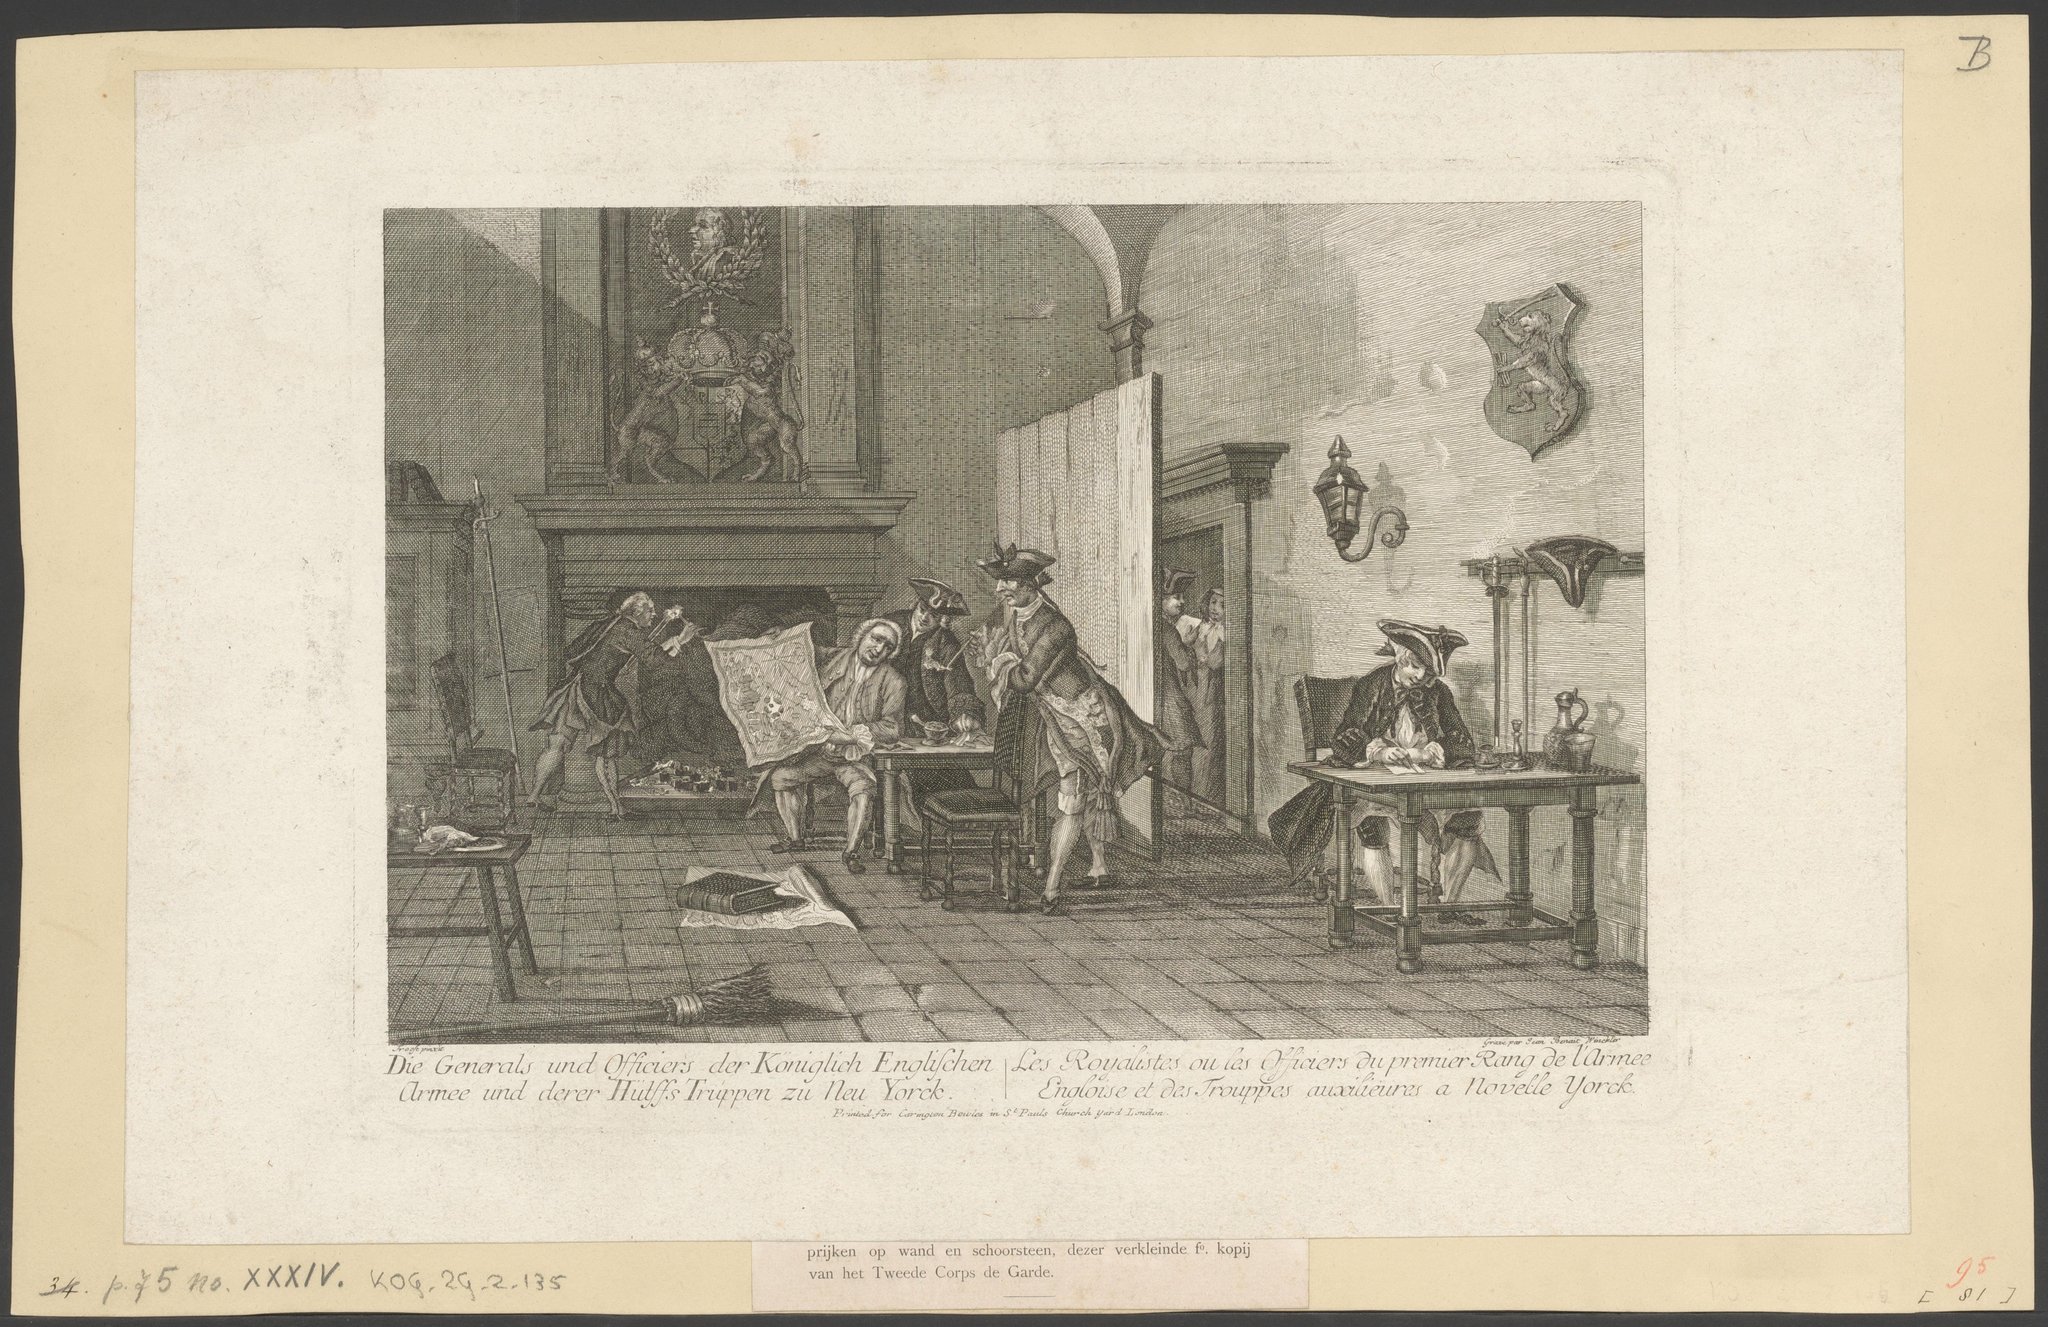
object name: print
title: Tweede corps de garde van Hollandsche officiers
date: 1766-1793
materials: paper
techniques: engraving, etching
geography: london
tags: open hearth, fire-place, handwriting, written text, in the guard-room, 'kortegaard', studying a map, meeting of soldiers and/or officers, new york (city)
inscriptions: collector's mark: Lugt 2488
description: Een interieur met verschillende officieren. Rechts zit een man aan een schrijftafel, links is een man bezig met vuur uit de open haard, in het midden kijken drie heren op een kaart. Boven de schoorsteen een wapenschild en daarboven een met een lauwerkrans omgeven portret van een man en profil. Deze kopie situeert de voorstelling in New York en behoren de afgebeelde militairen tot het Engelse leger. Verkleinde kopie met Duits en Frans onderschrift.